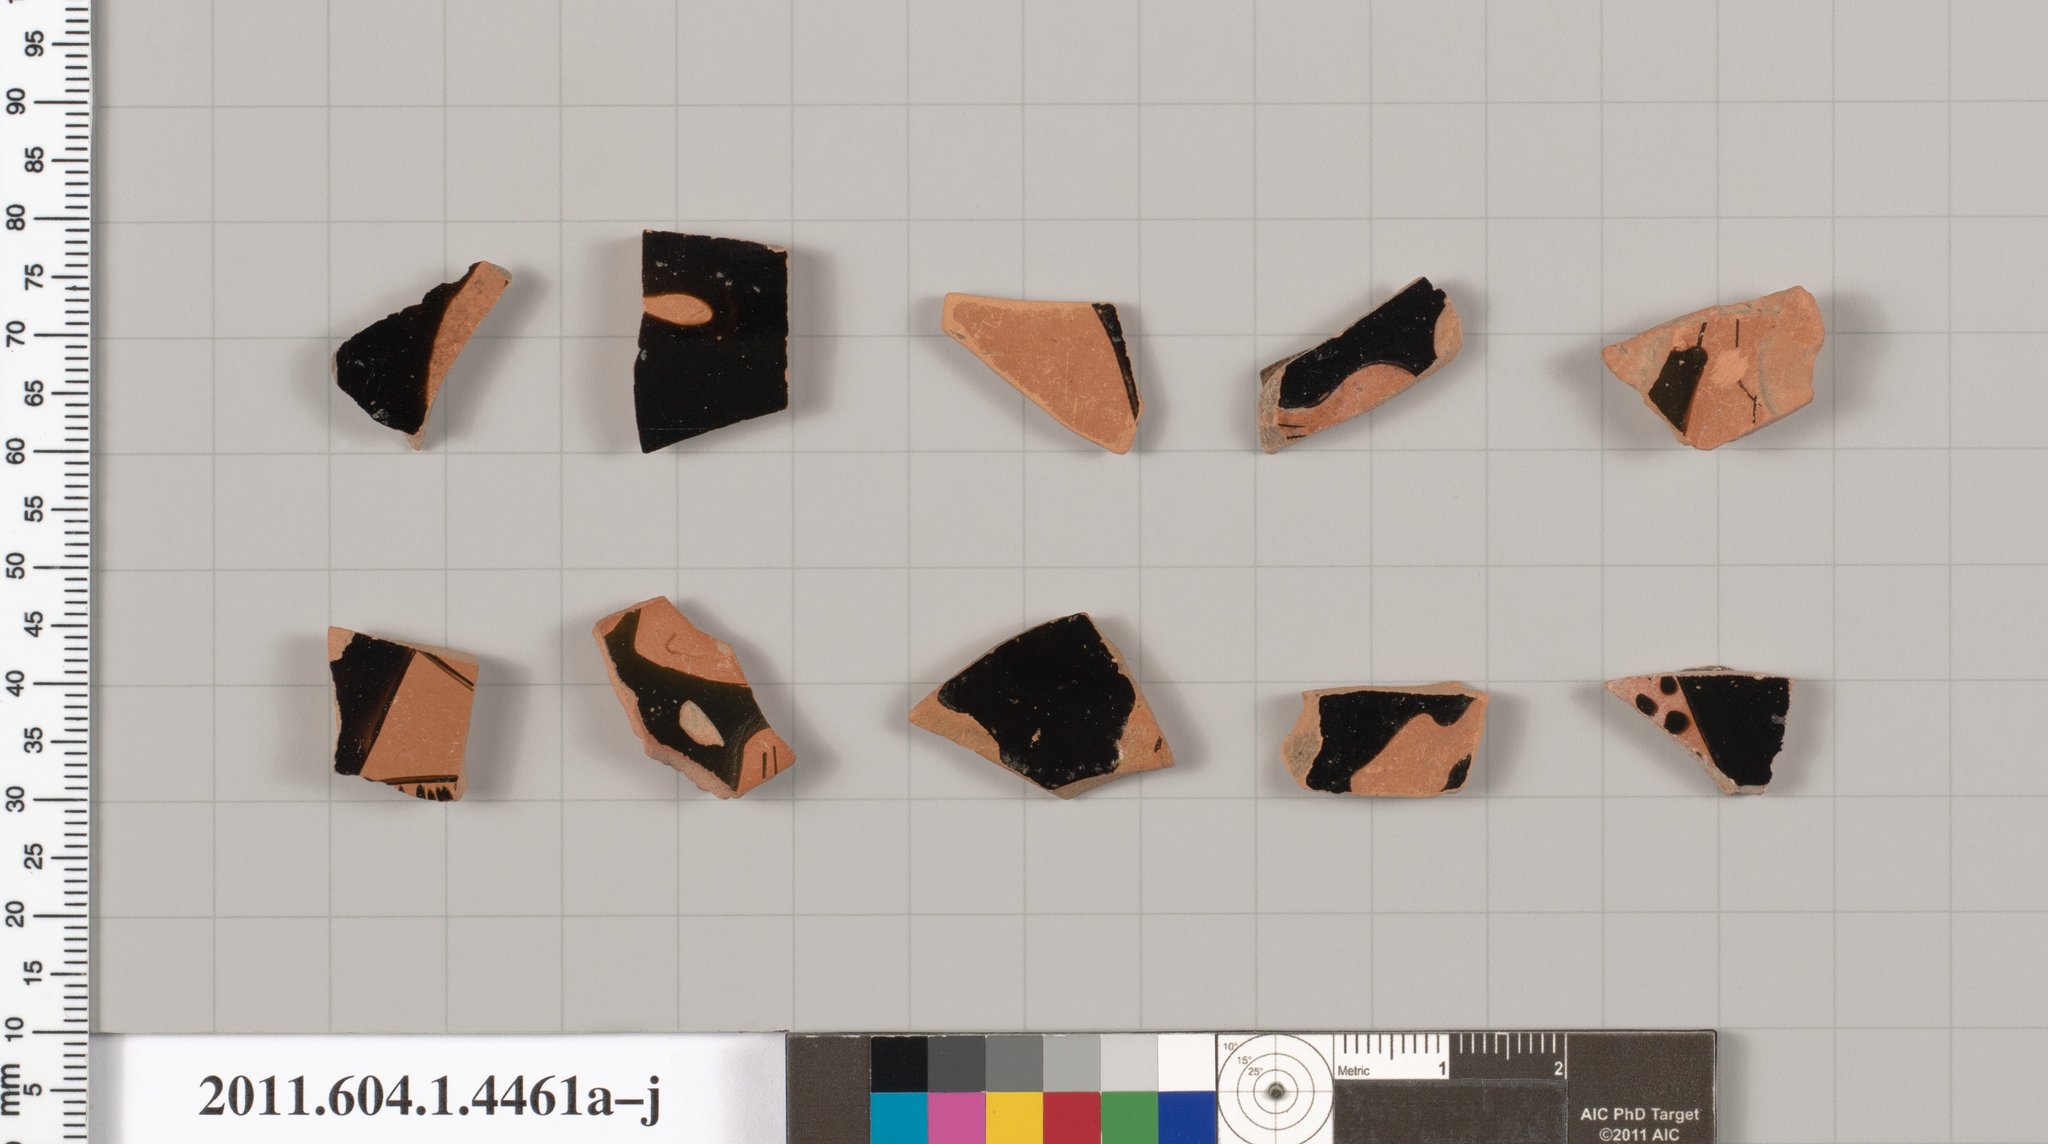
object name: kylix fragment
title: Terracotta fragments of kylikes (drinking cups)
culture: greek, attic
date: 500-451 BCE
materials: terracotta